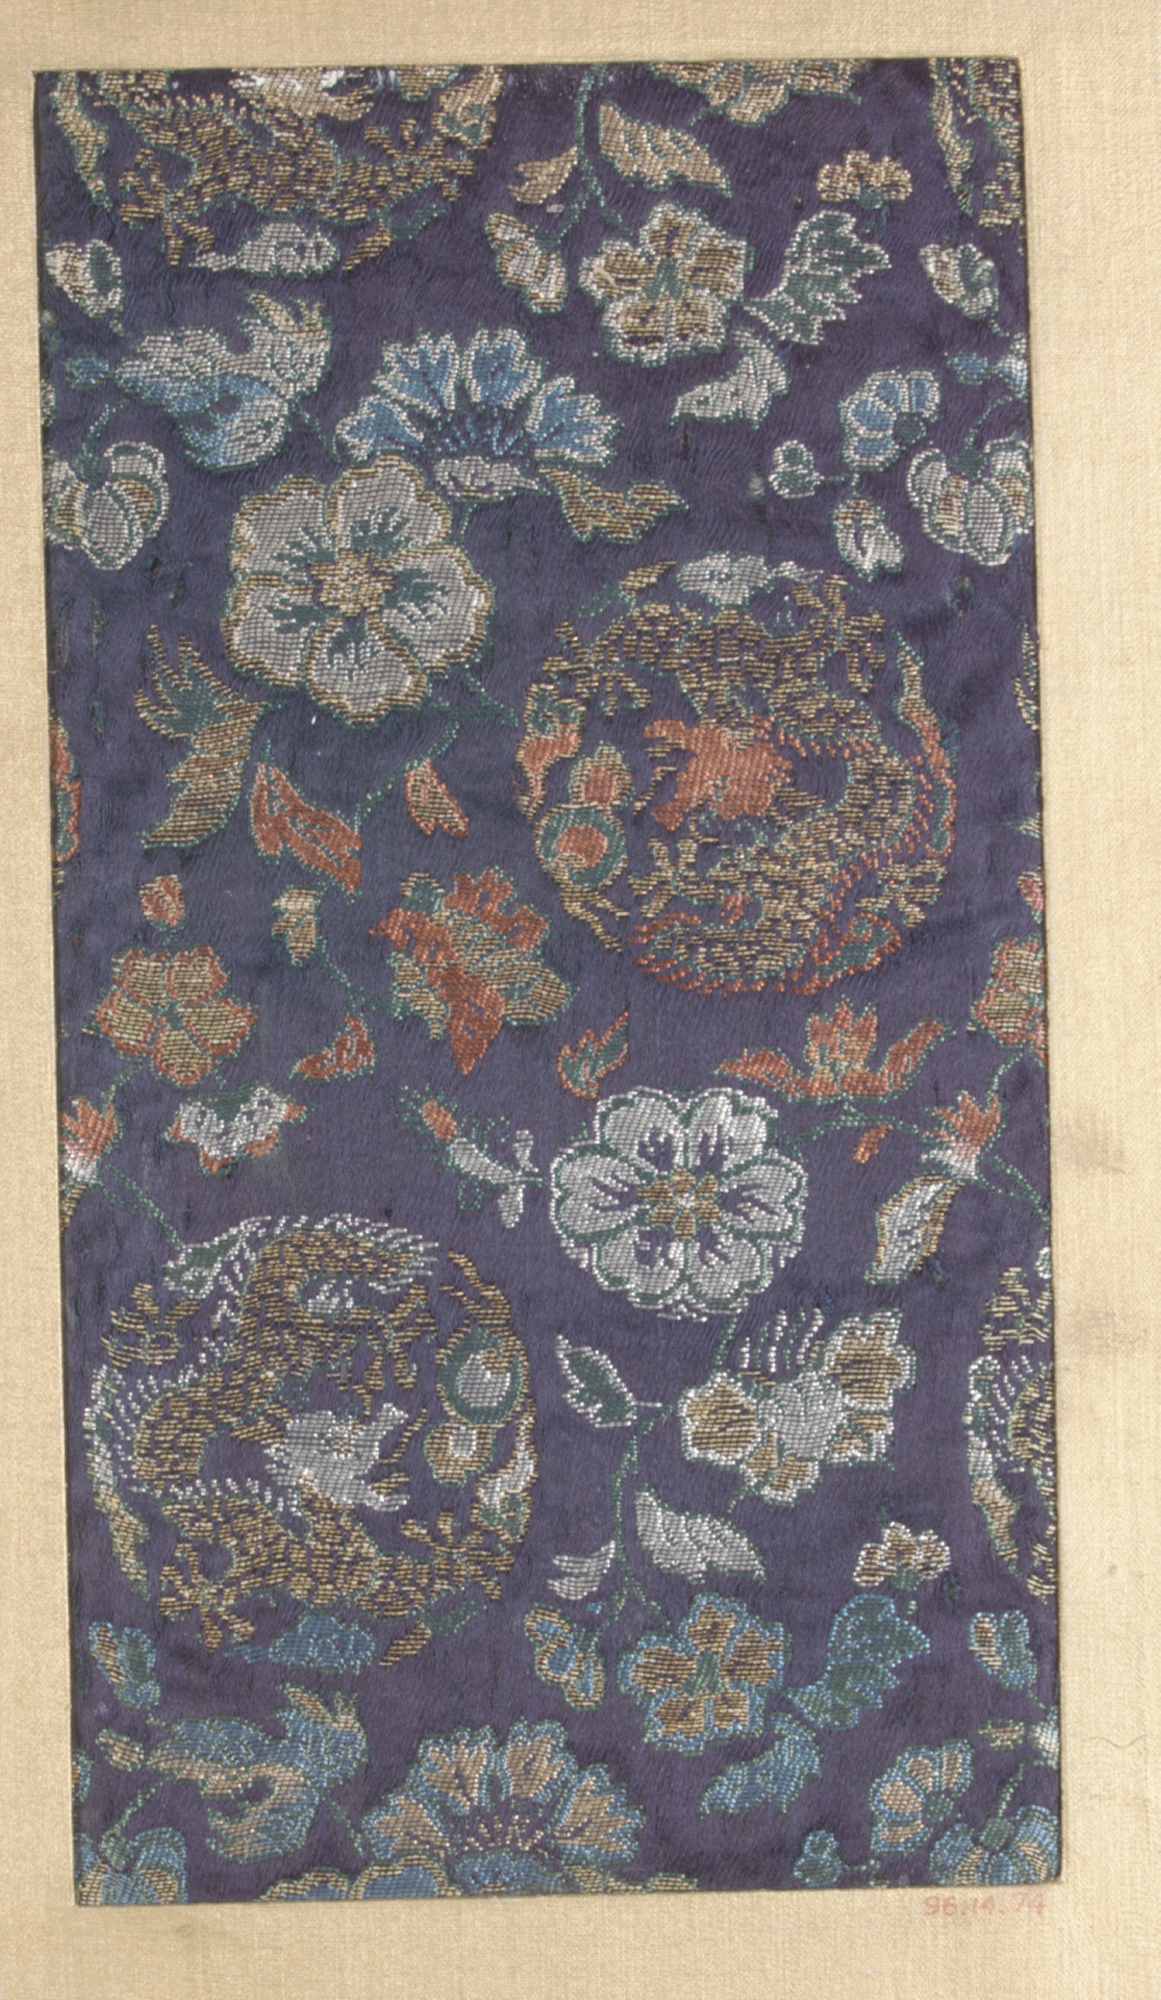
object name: piece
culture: japanese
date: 1701-1900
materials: silk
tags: flowers